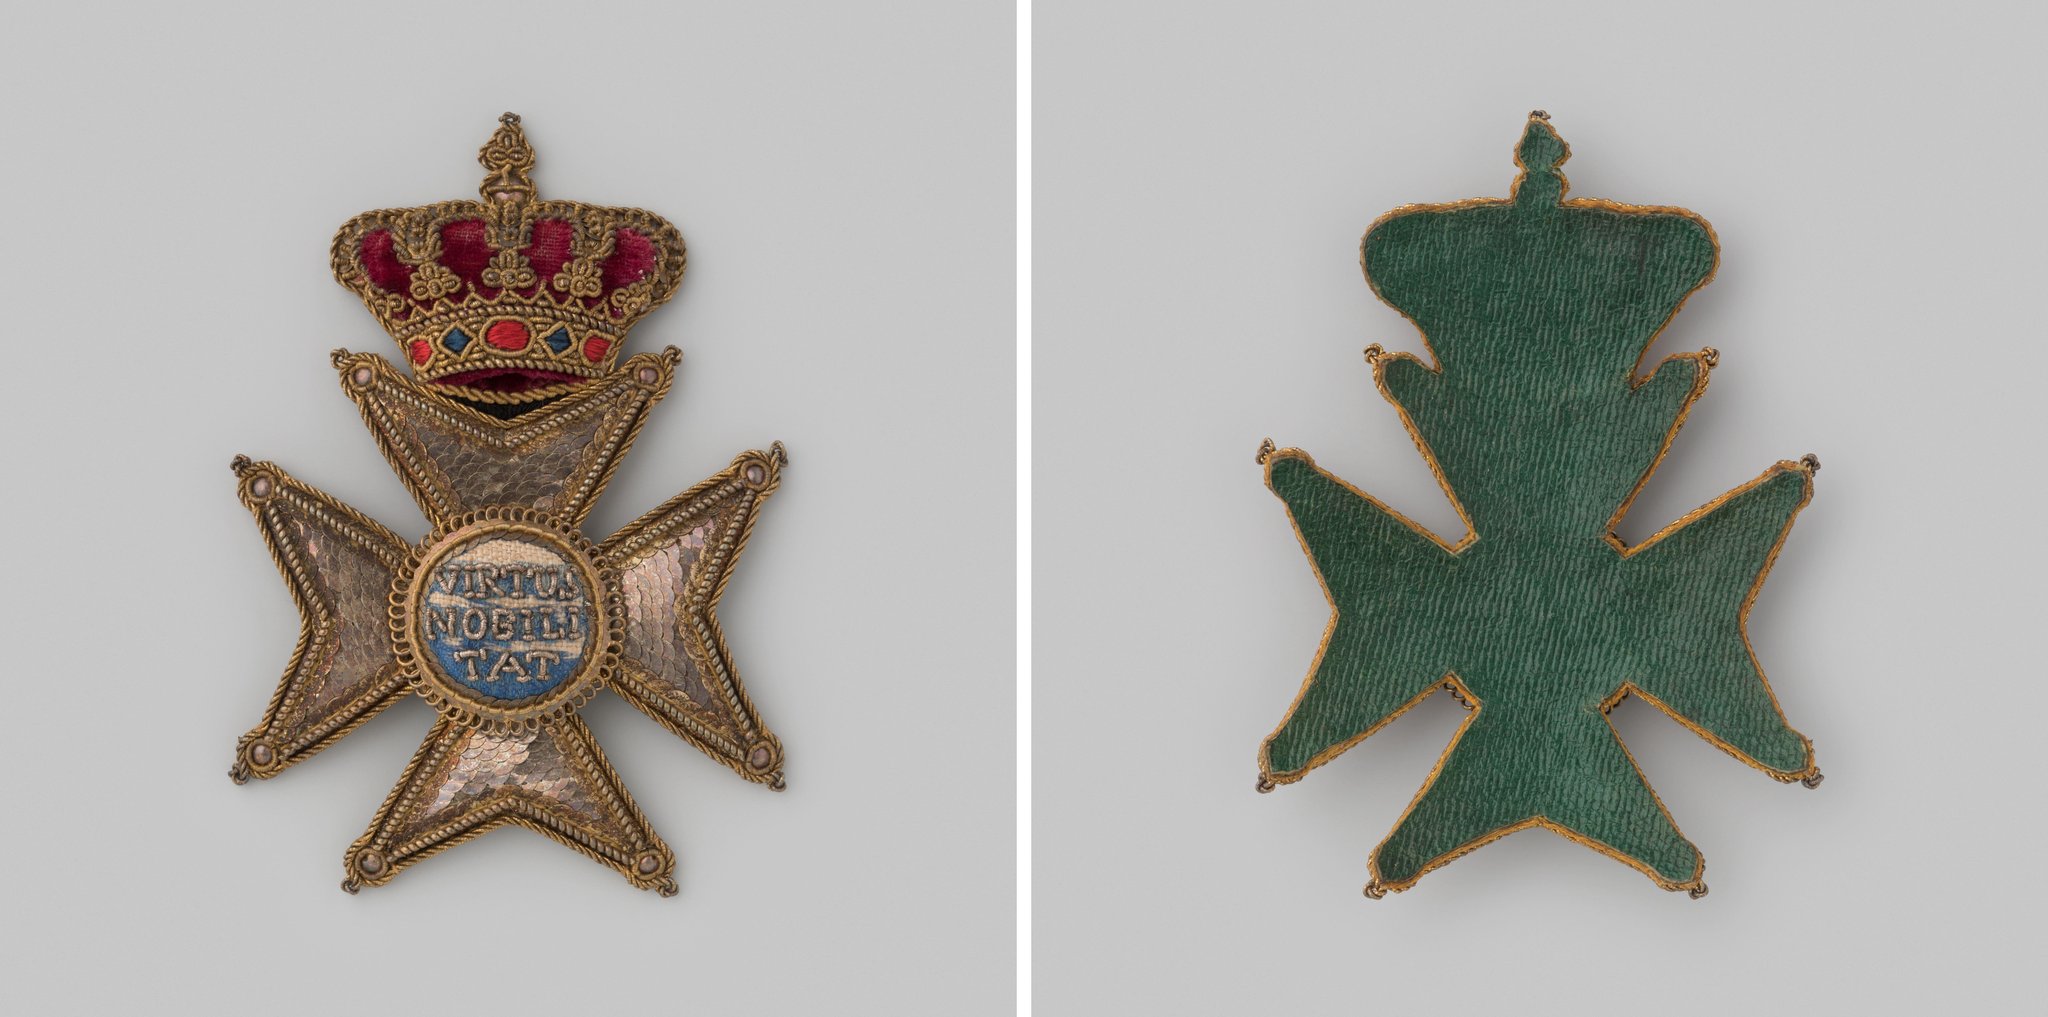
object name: honorary medal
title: Ereteken met borduursel in de vorm van een kruis voor commandeur in de orde van de Nederlandse Leeuw, uitgereikt voor virtus nobilitat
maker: Anonymous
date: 1815-1894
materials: gold, silver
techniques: gilding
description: Verguld zilveren draagteken met verguld borduursel, email en gouden versieringen.